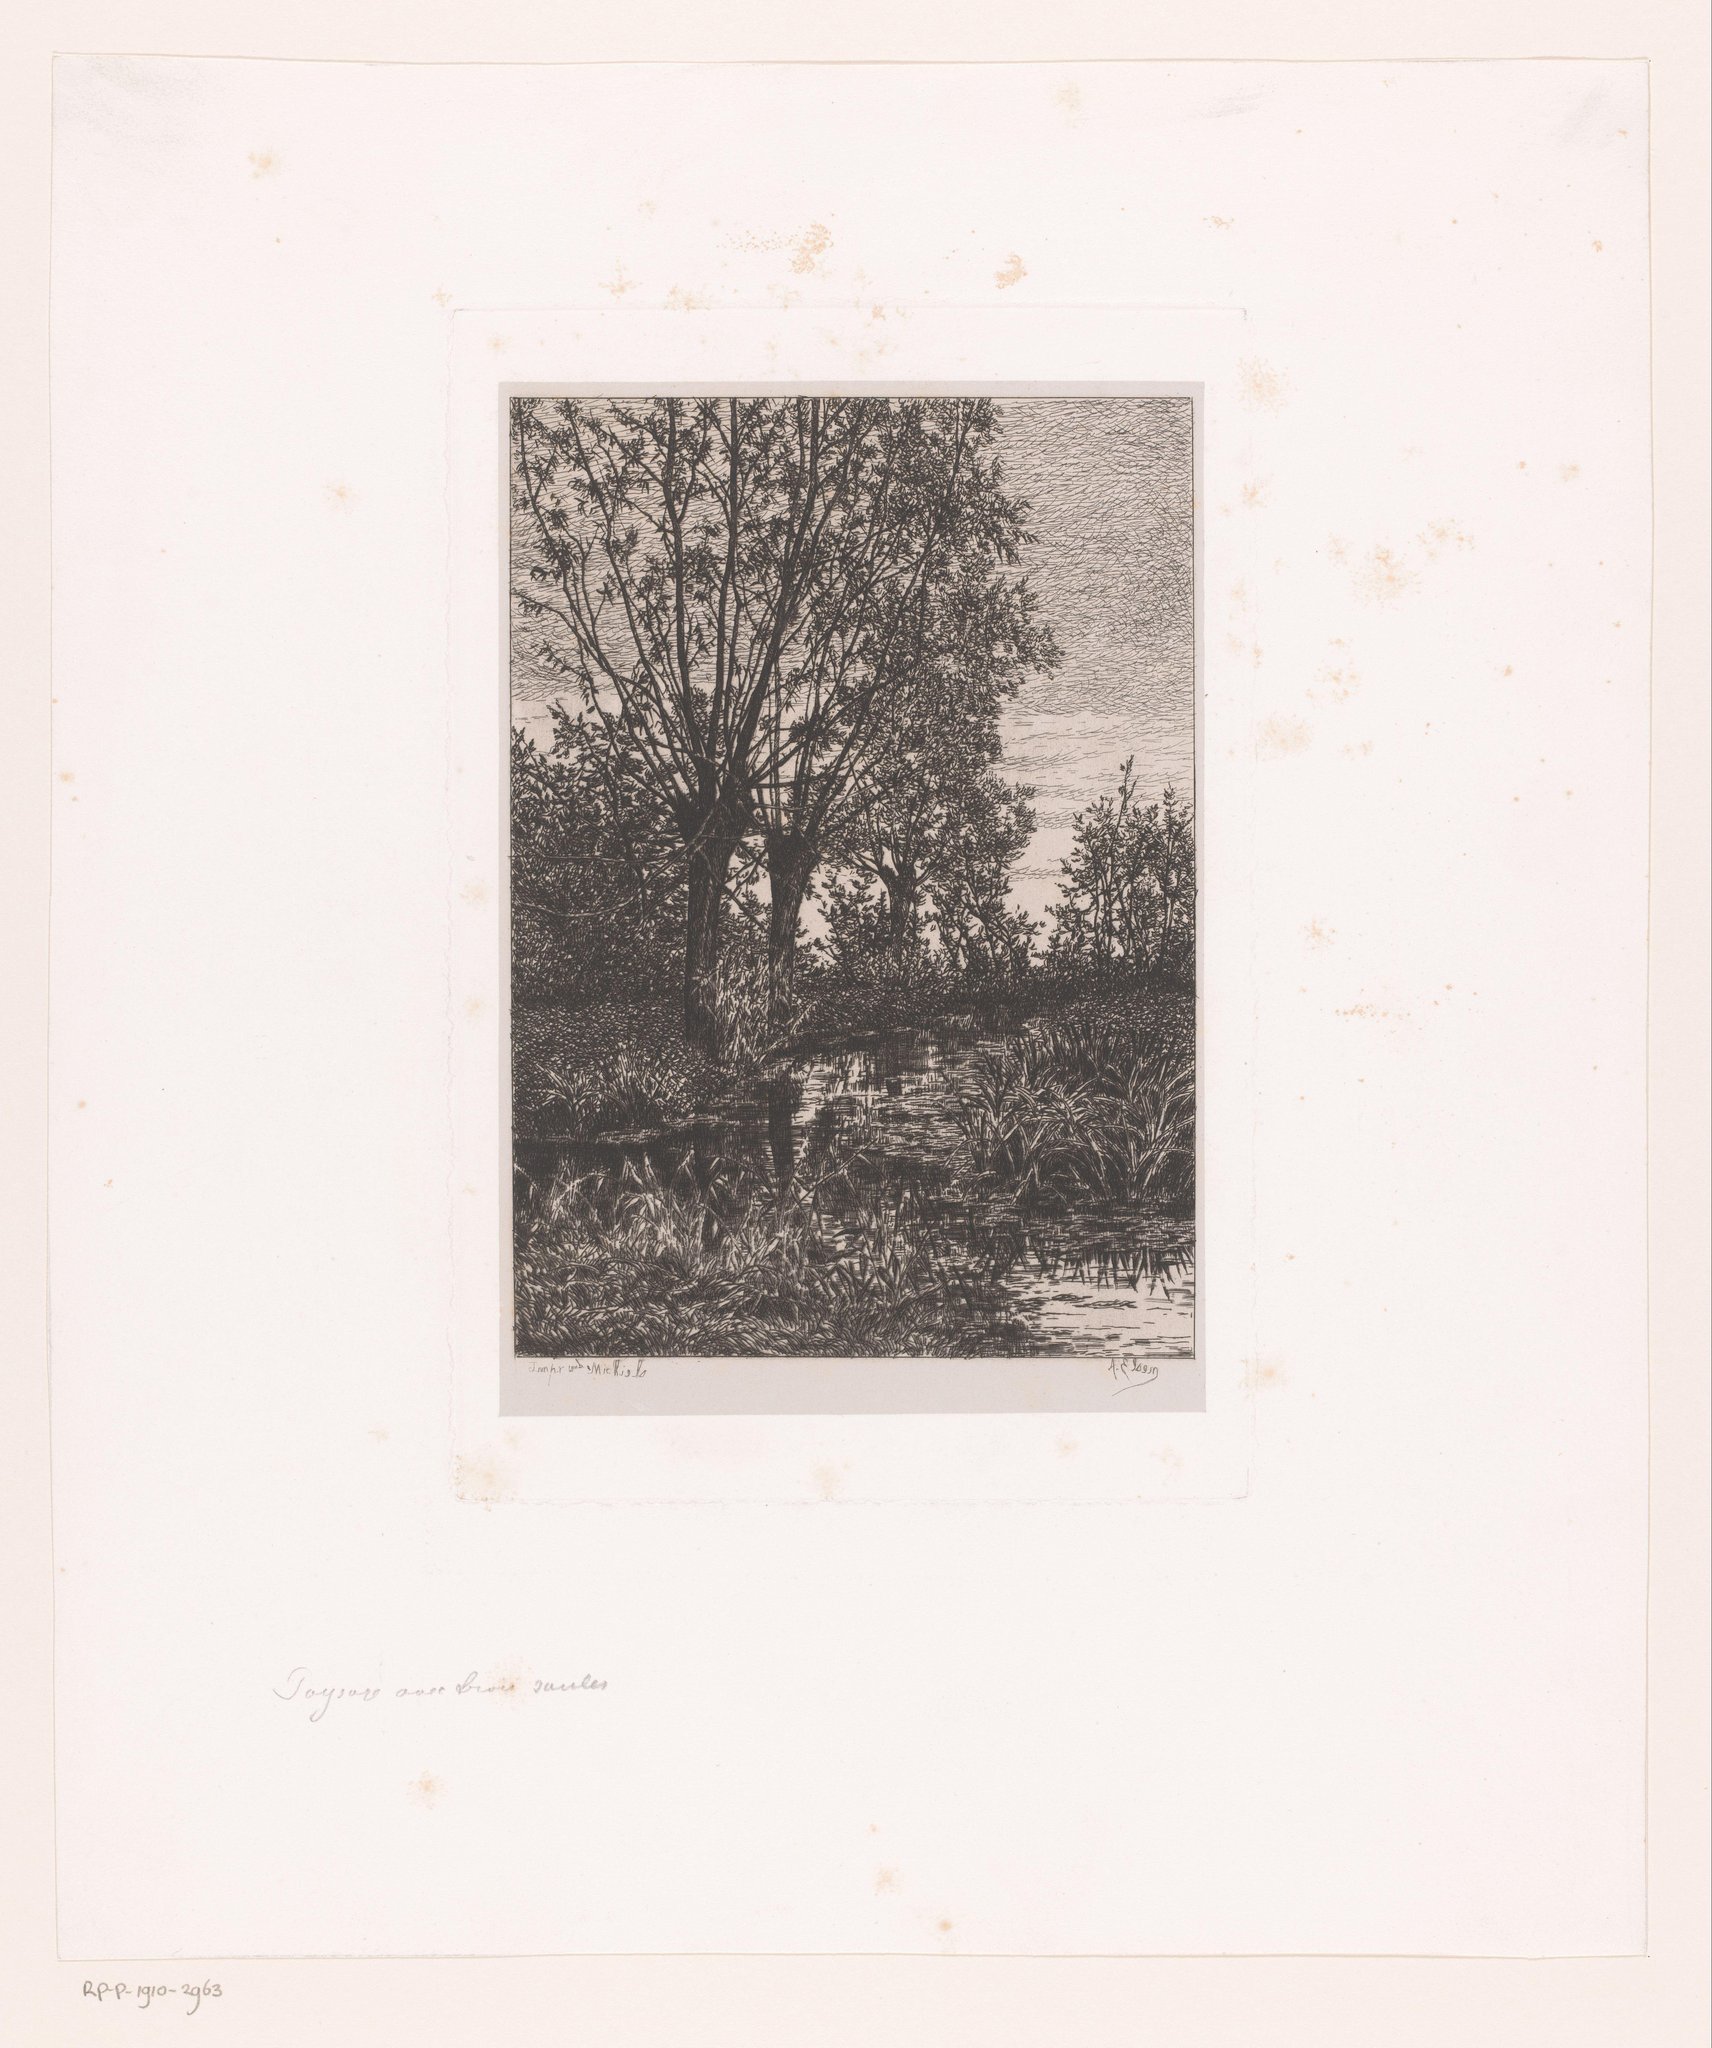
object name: print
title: Landschap met drie wilgen langs het water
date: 1860-1910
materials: paper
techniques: etching, intaglio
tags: brook, trees: willow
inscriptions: collector's mark: Lugt 2228, inscription